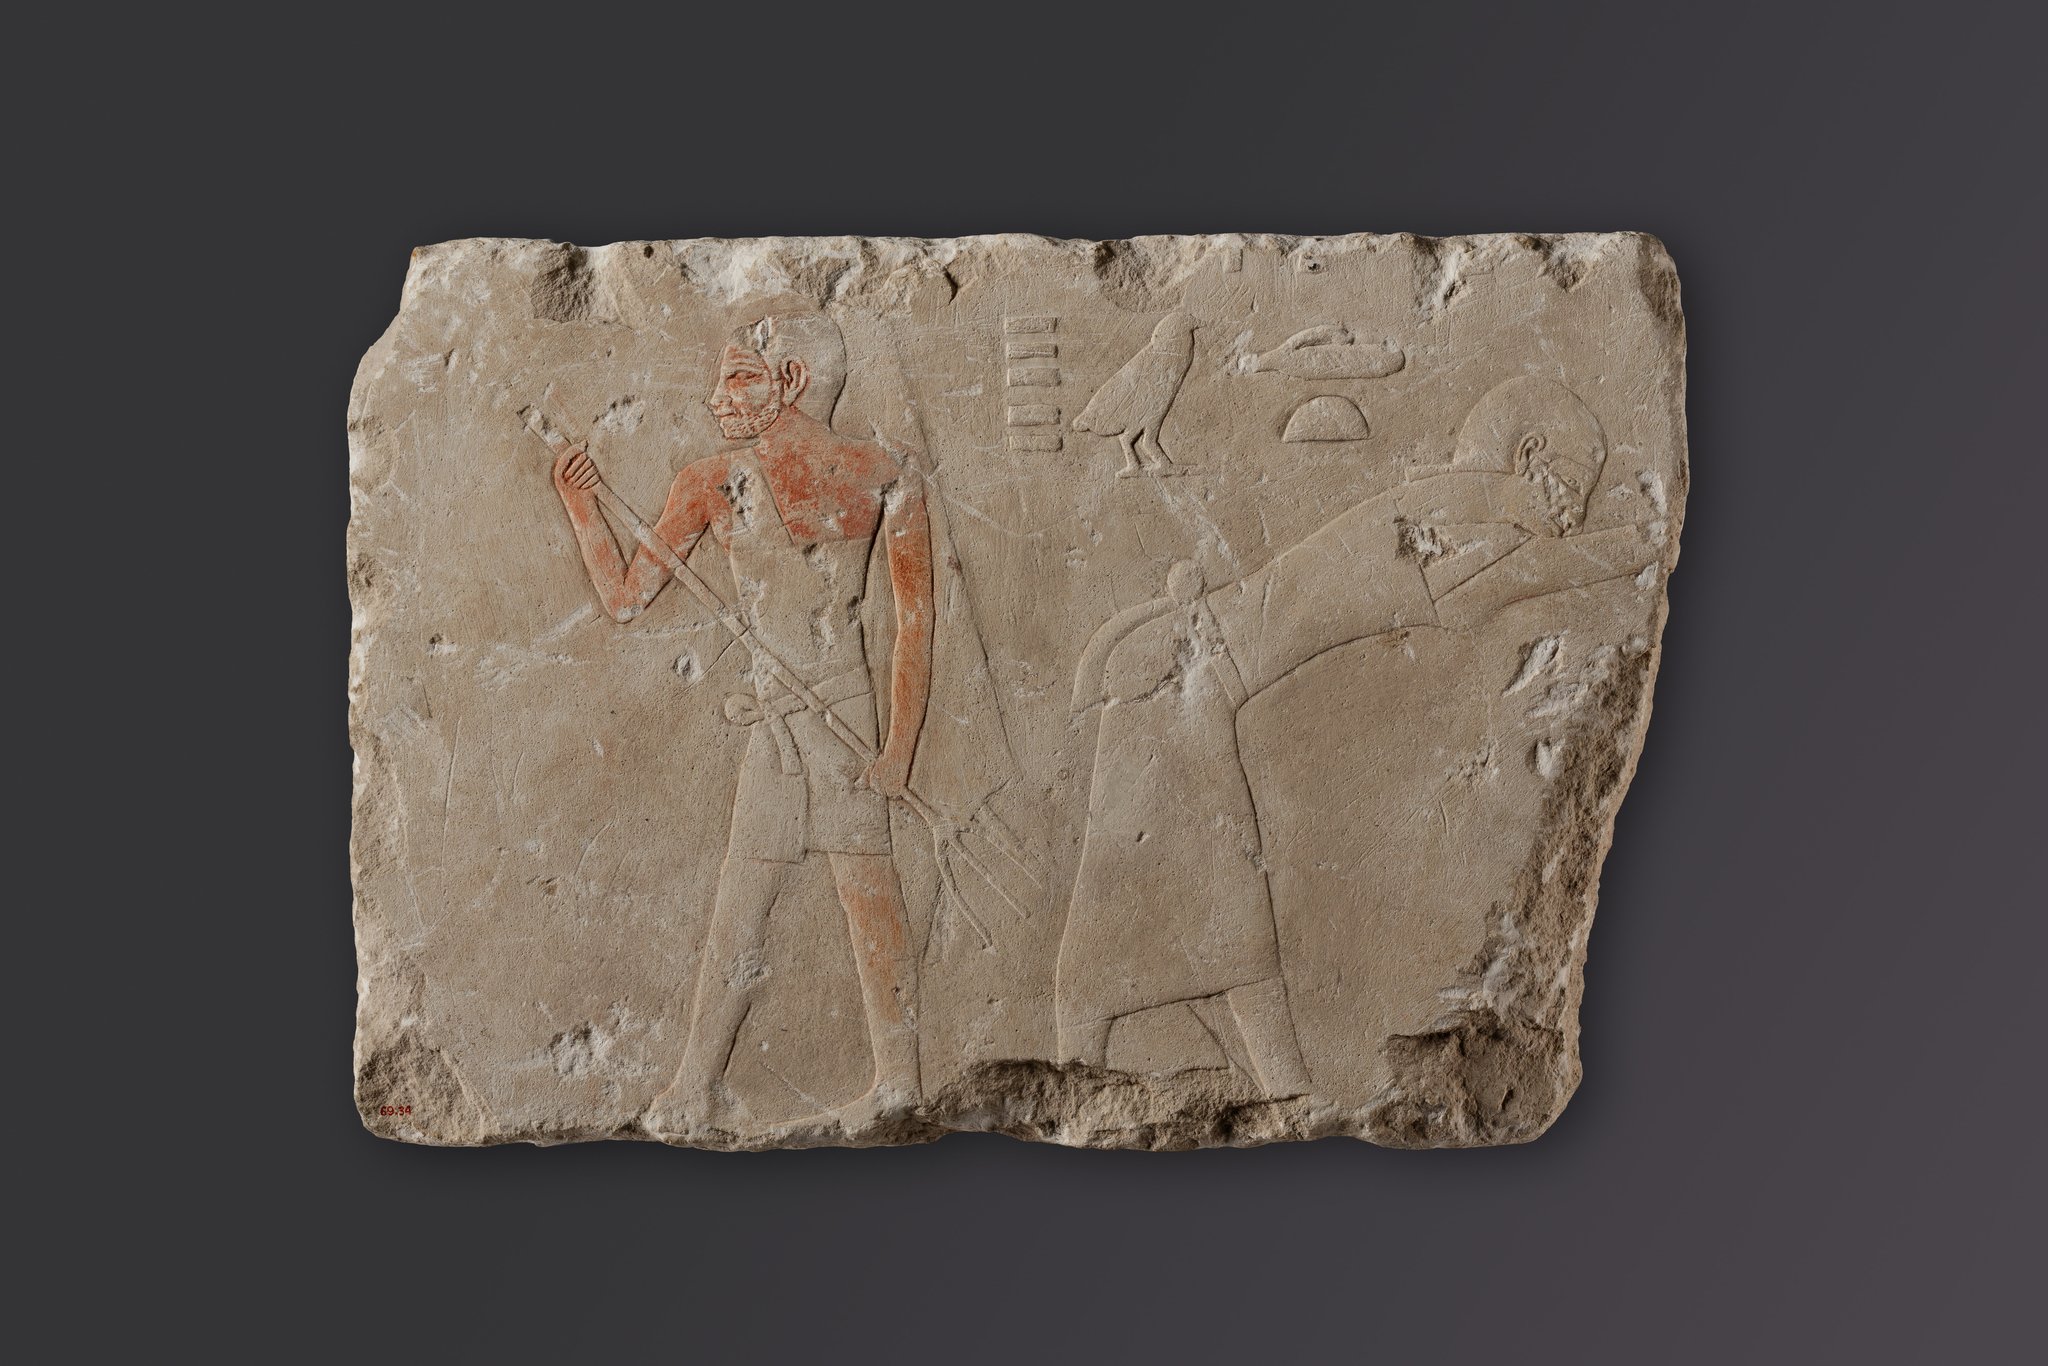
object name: relief, fragment, winnowing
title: Relief fragment depicting two figures winnowing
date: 2323-2150 BCE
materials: limestone, pigment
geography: egypt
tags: men,working